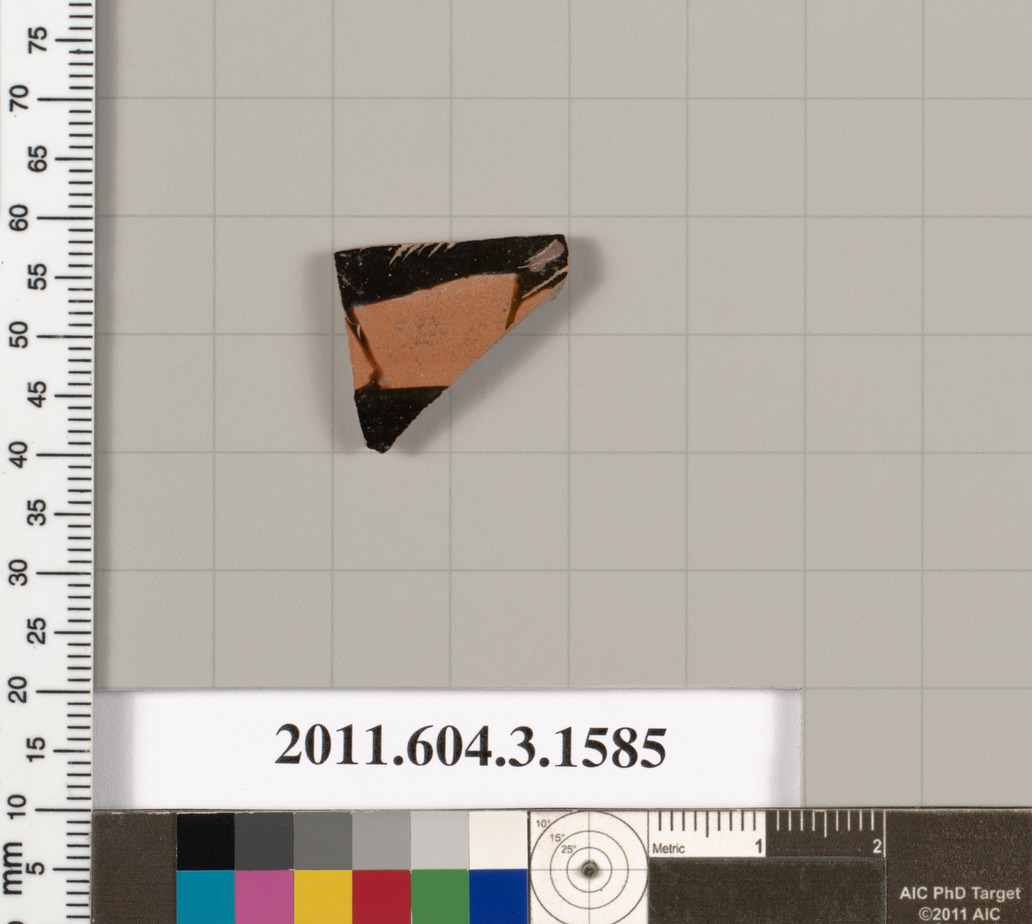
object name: kylix fragment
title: Terracotta fragment of a kylix: Band cup (drinking cup)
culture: greek, attic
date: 550-526 BCE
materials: terracotta